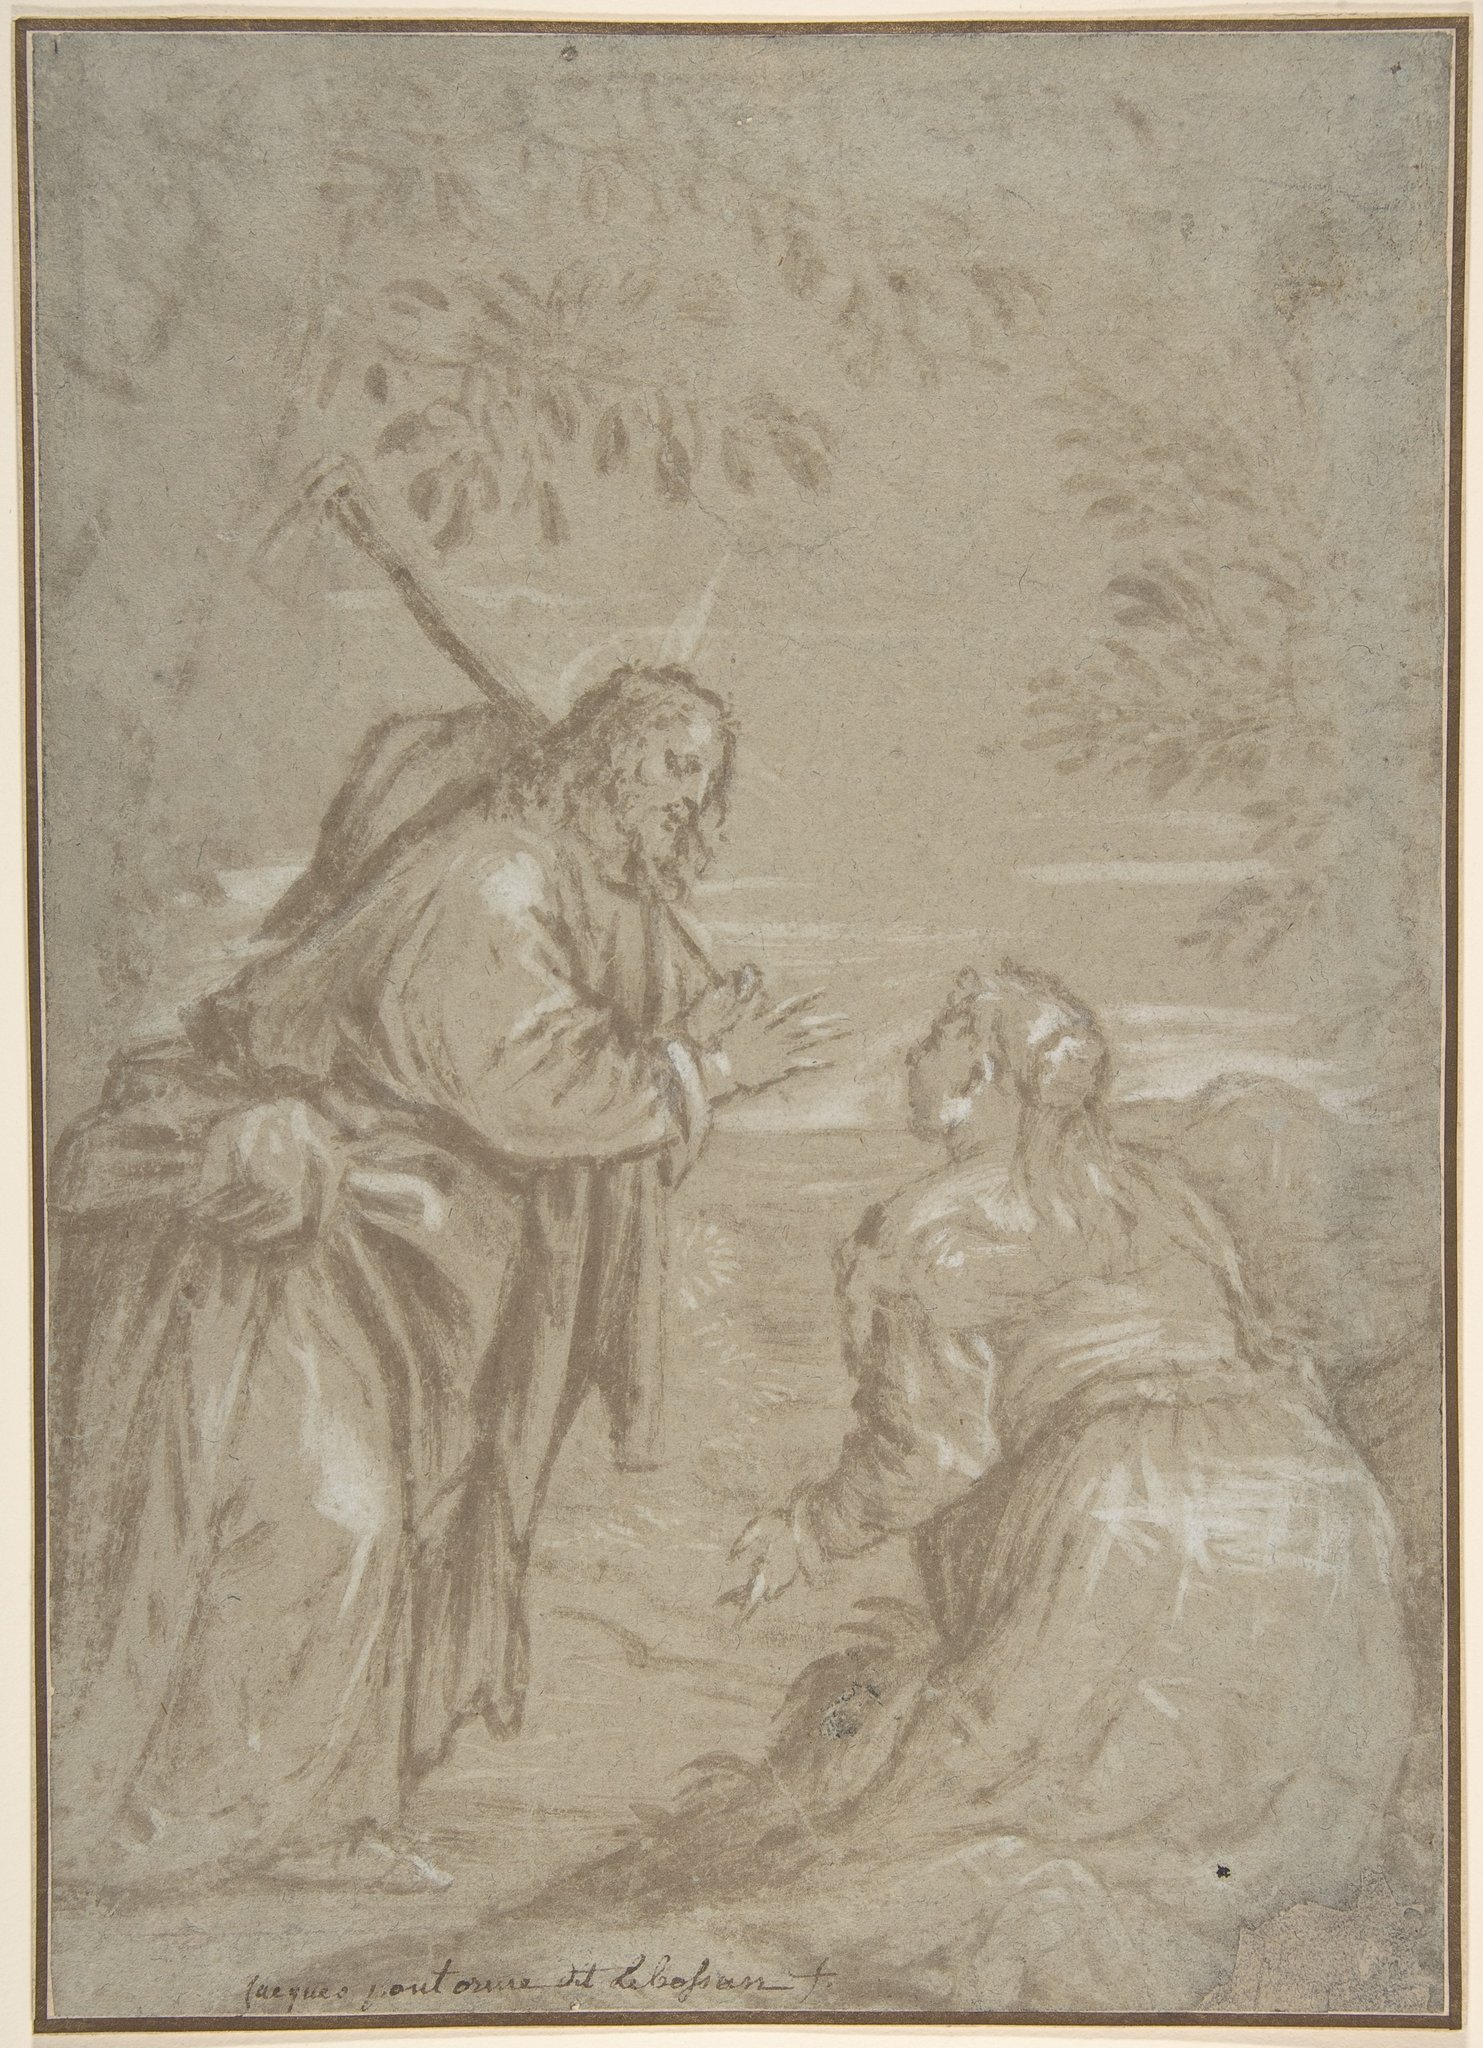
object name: drawing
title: Christ Appearing to Saint Mary Magdalen ("Noli Me Tangere")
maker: jacopo bassano (jacopo da ponte)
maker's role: artist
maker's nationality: italian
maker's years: 1510-1592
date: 1560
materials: chalk, gouache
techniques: brush, highlighting, wash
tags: christ,mary magdalene